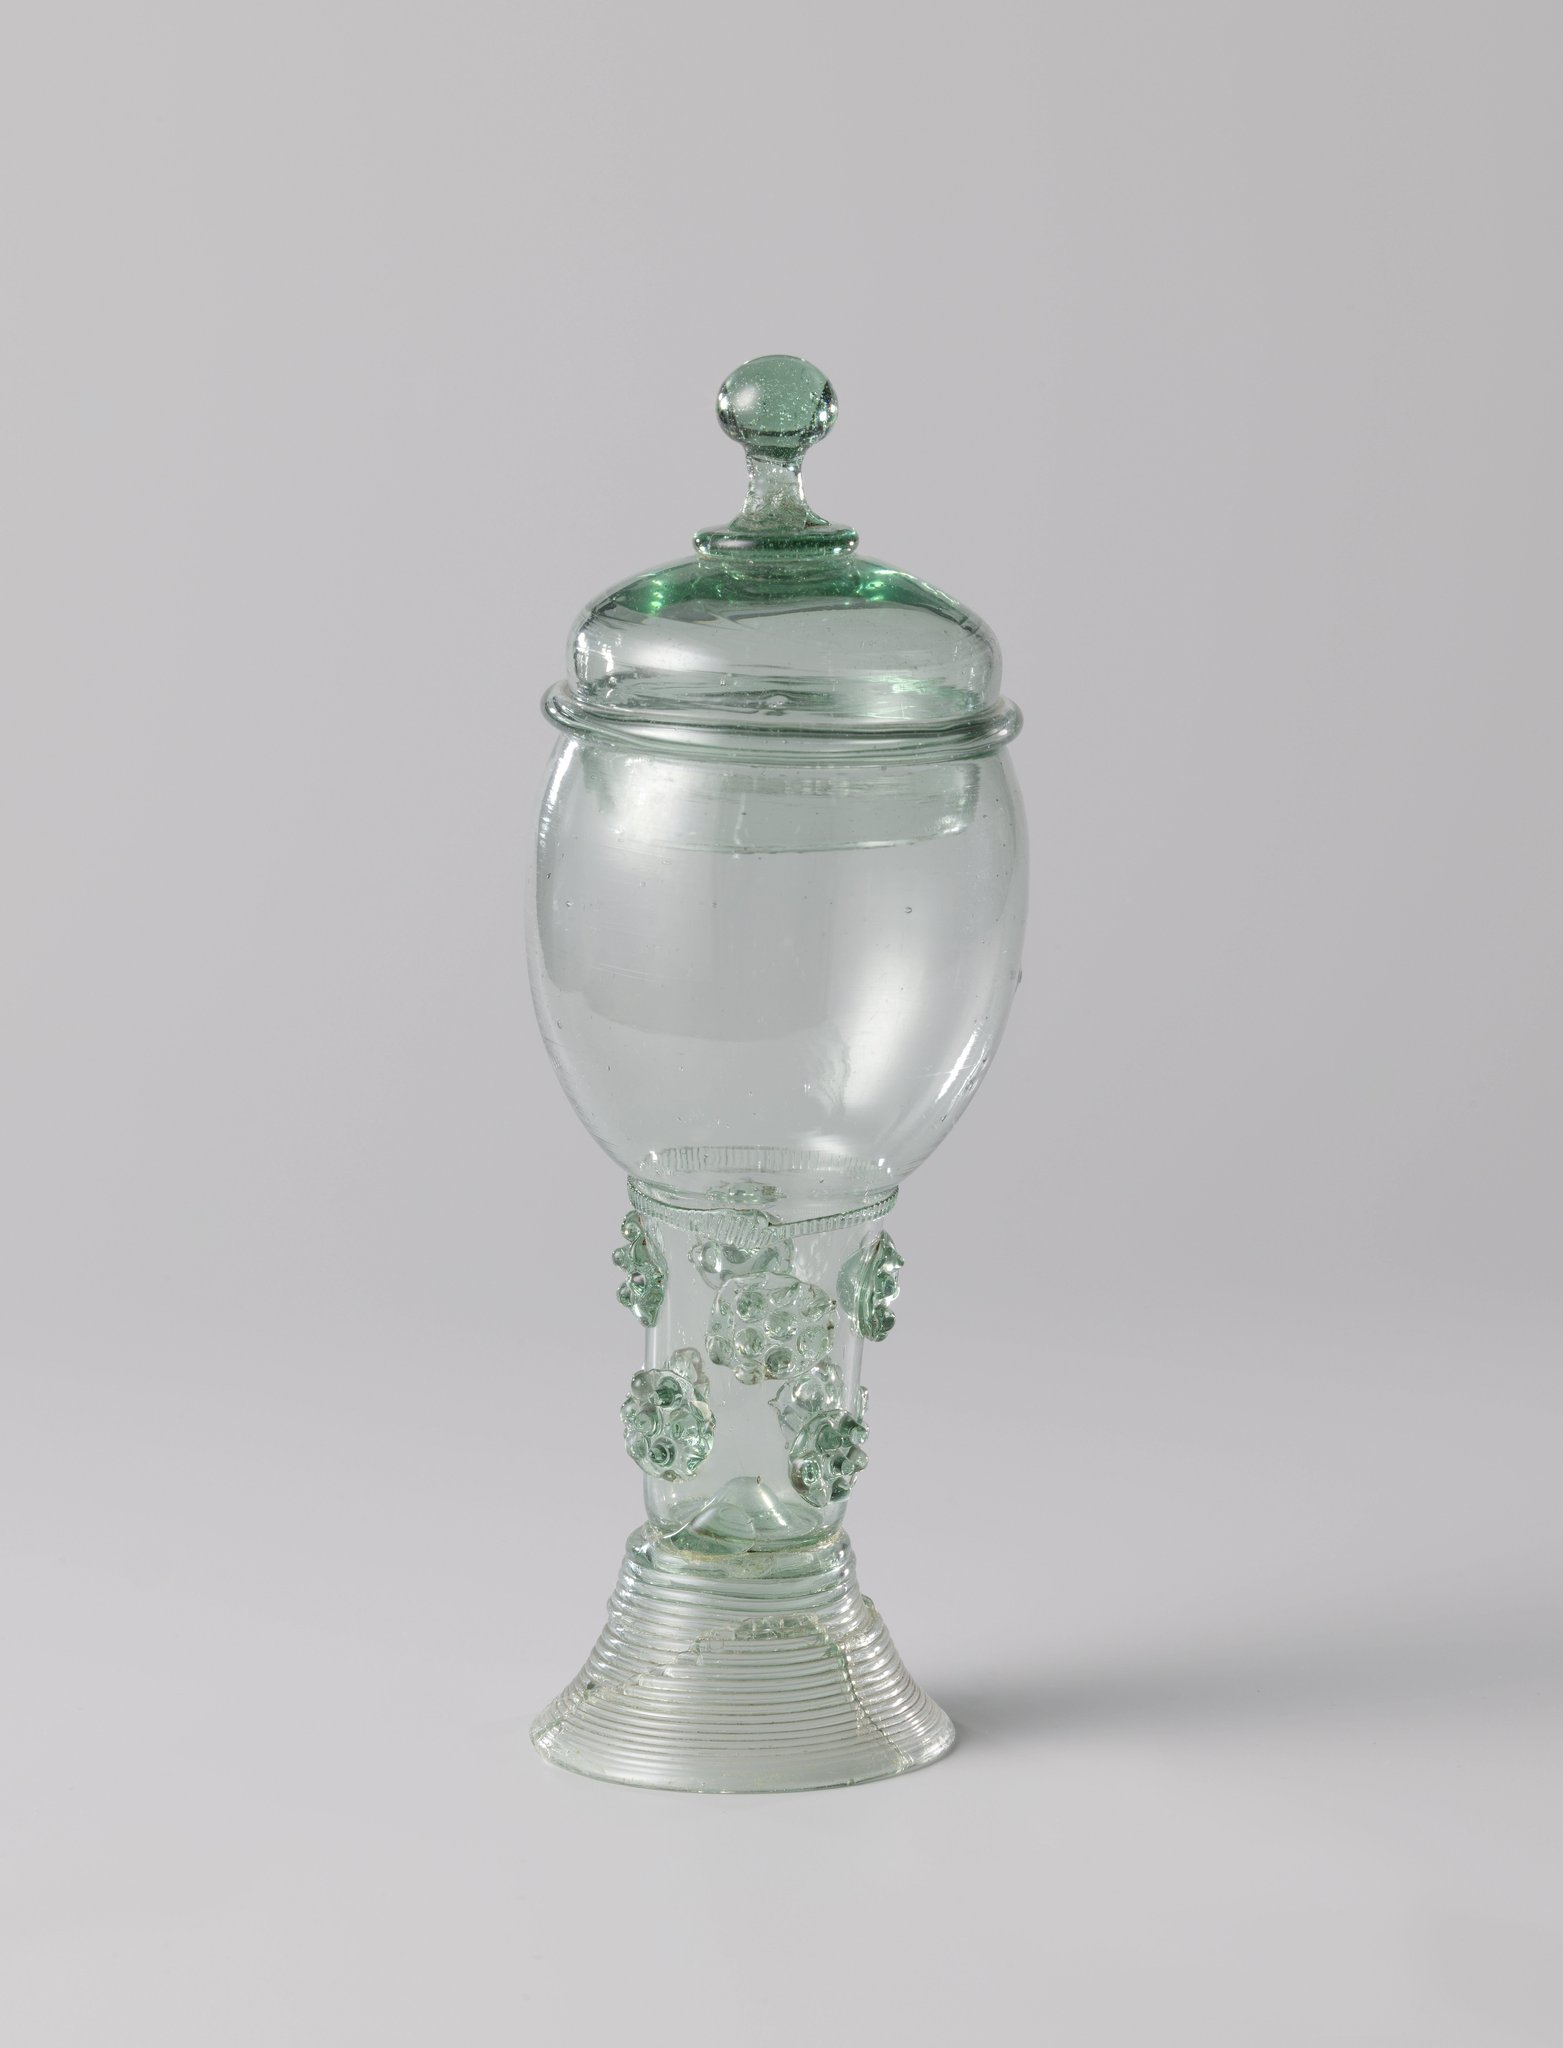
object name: lid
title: Deksel van roemer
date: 1690-1800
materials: glass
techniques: glassblowing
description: Gewelfd deksel met een uitkragende rand en een massieve bolle knop.